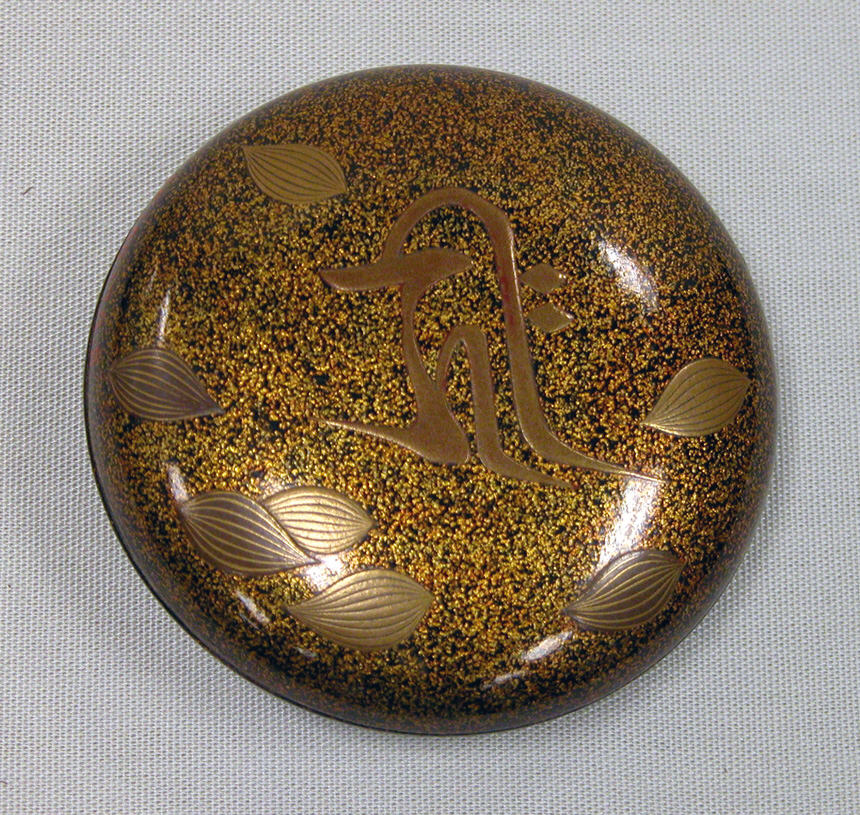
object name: box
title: Portable Shrine of Miroku Bosatsu with Sacred Sanskrit Syllable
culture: japanese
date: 1801-1900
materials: gold, lacquer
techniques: maki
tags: men,buddhism,bodhisattvas